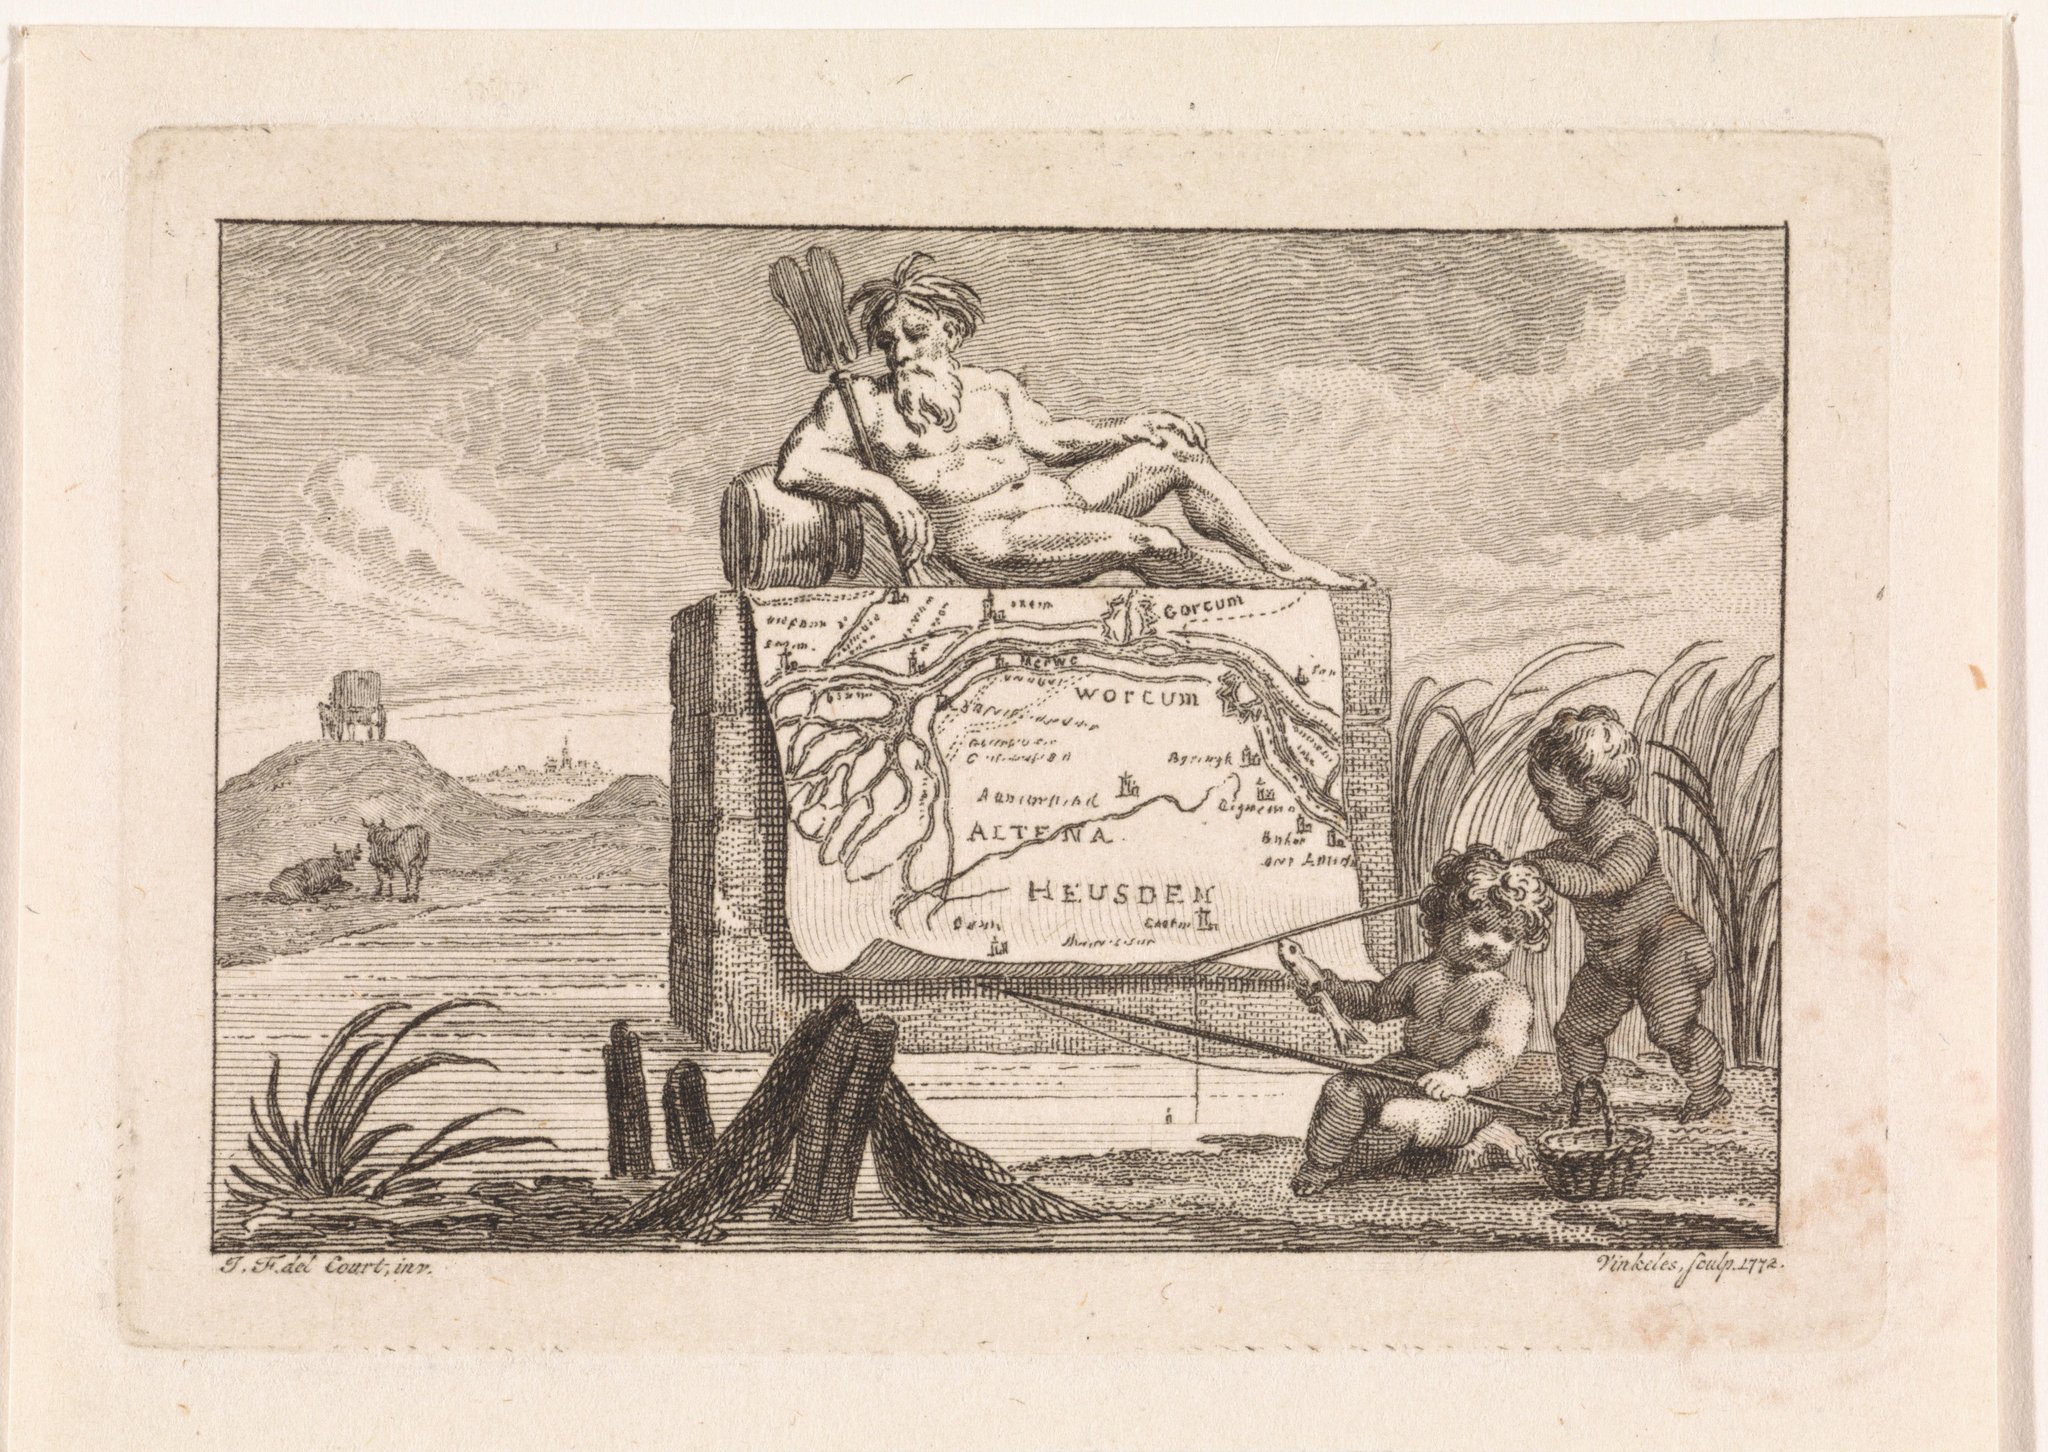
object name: print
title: Landschap met twee putti en een riviergod bij een kaart van het Land van Heusden en Altena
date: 1772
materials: paper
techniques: engraving, etching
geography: amsterdam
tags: landscapes, maps of separate countries or regions, cupids: 'amores', 'amoretti', 'putti'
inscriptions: collector's mark: Lugt 240